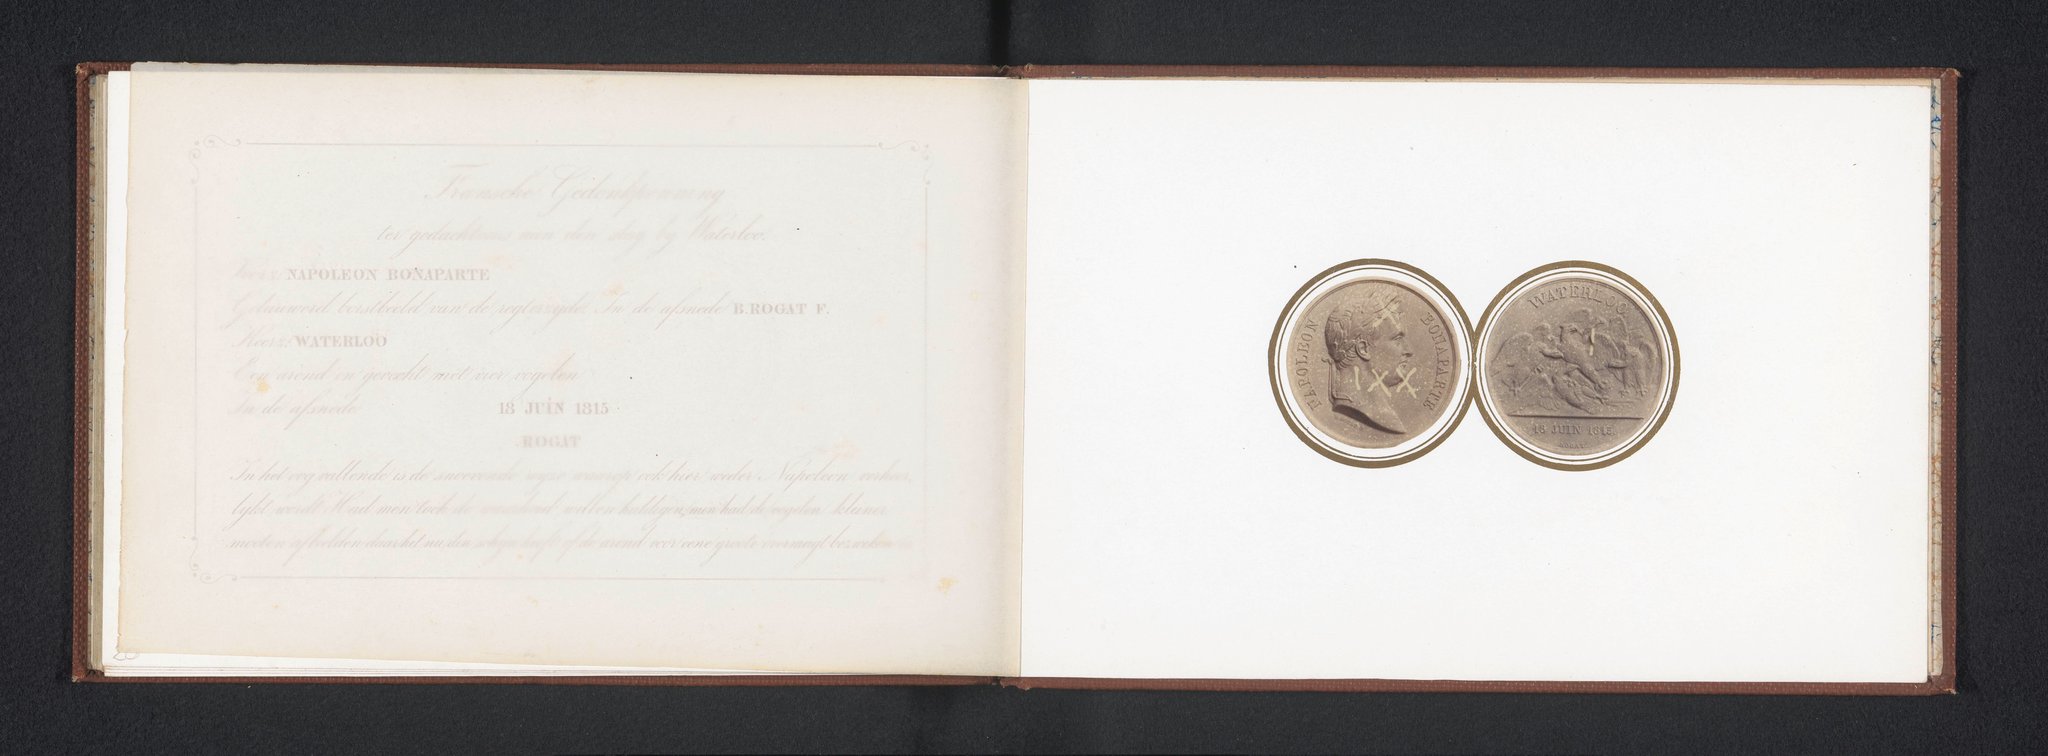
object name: page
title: Twee afbeeldingen van een Franse gedenkpenning in nagedachtenis van de Slag bij Waterloo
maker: willem matla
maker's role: fotograaf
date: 1865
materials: paper, photographic support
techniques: albumen print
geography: the hague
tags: predatory birds: eagle, memorial medal, adult man (+ sideview, profile)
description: Links de voorzijde met een buste van Napoleon Bonaparte, rechts de keerzijde met een arend in gevecht met vier vogels.